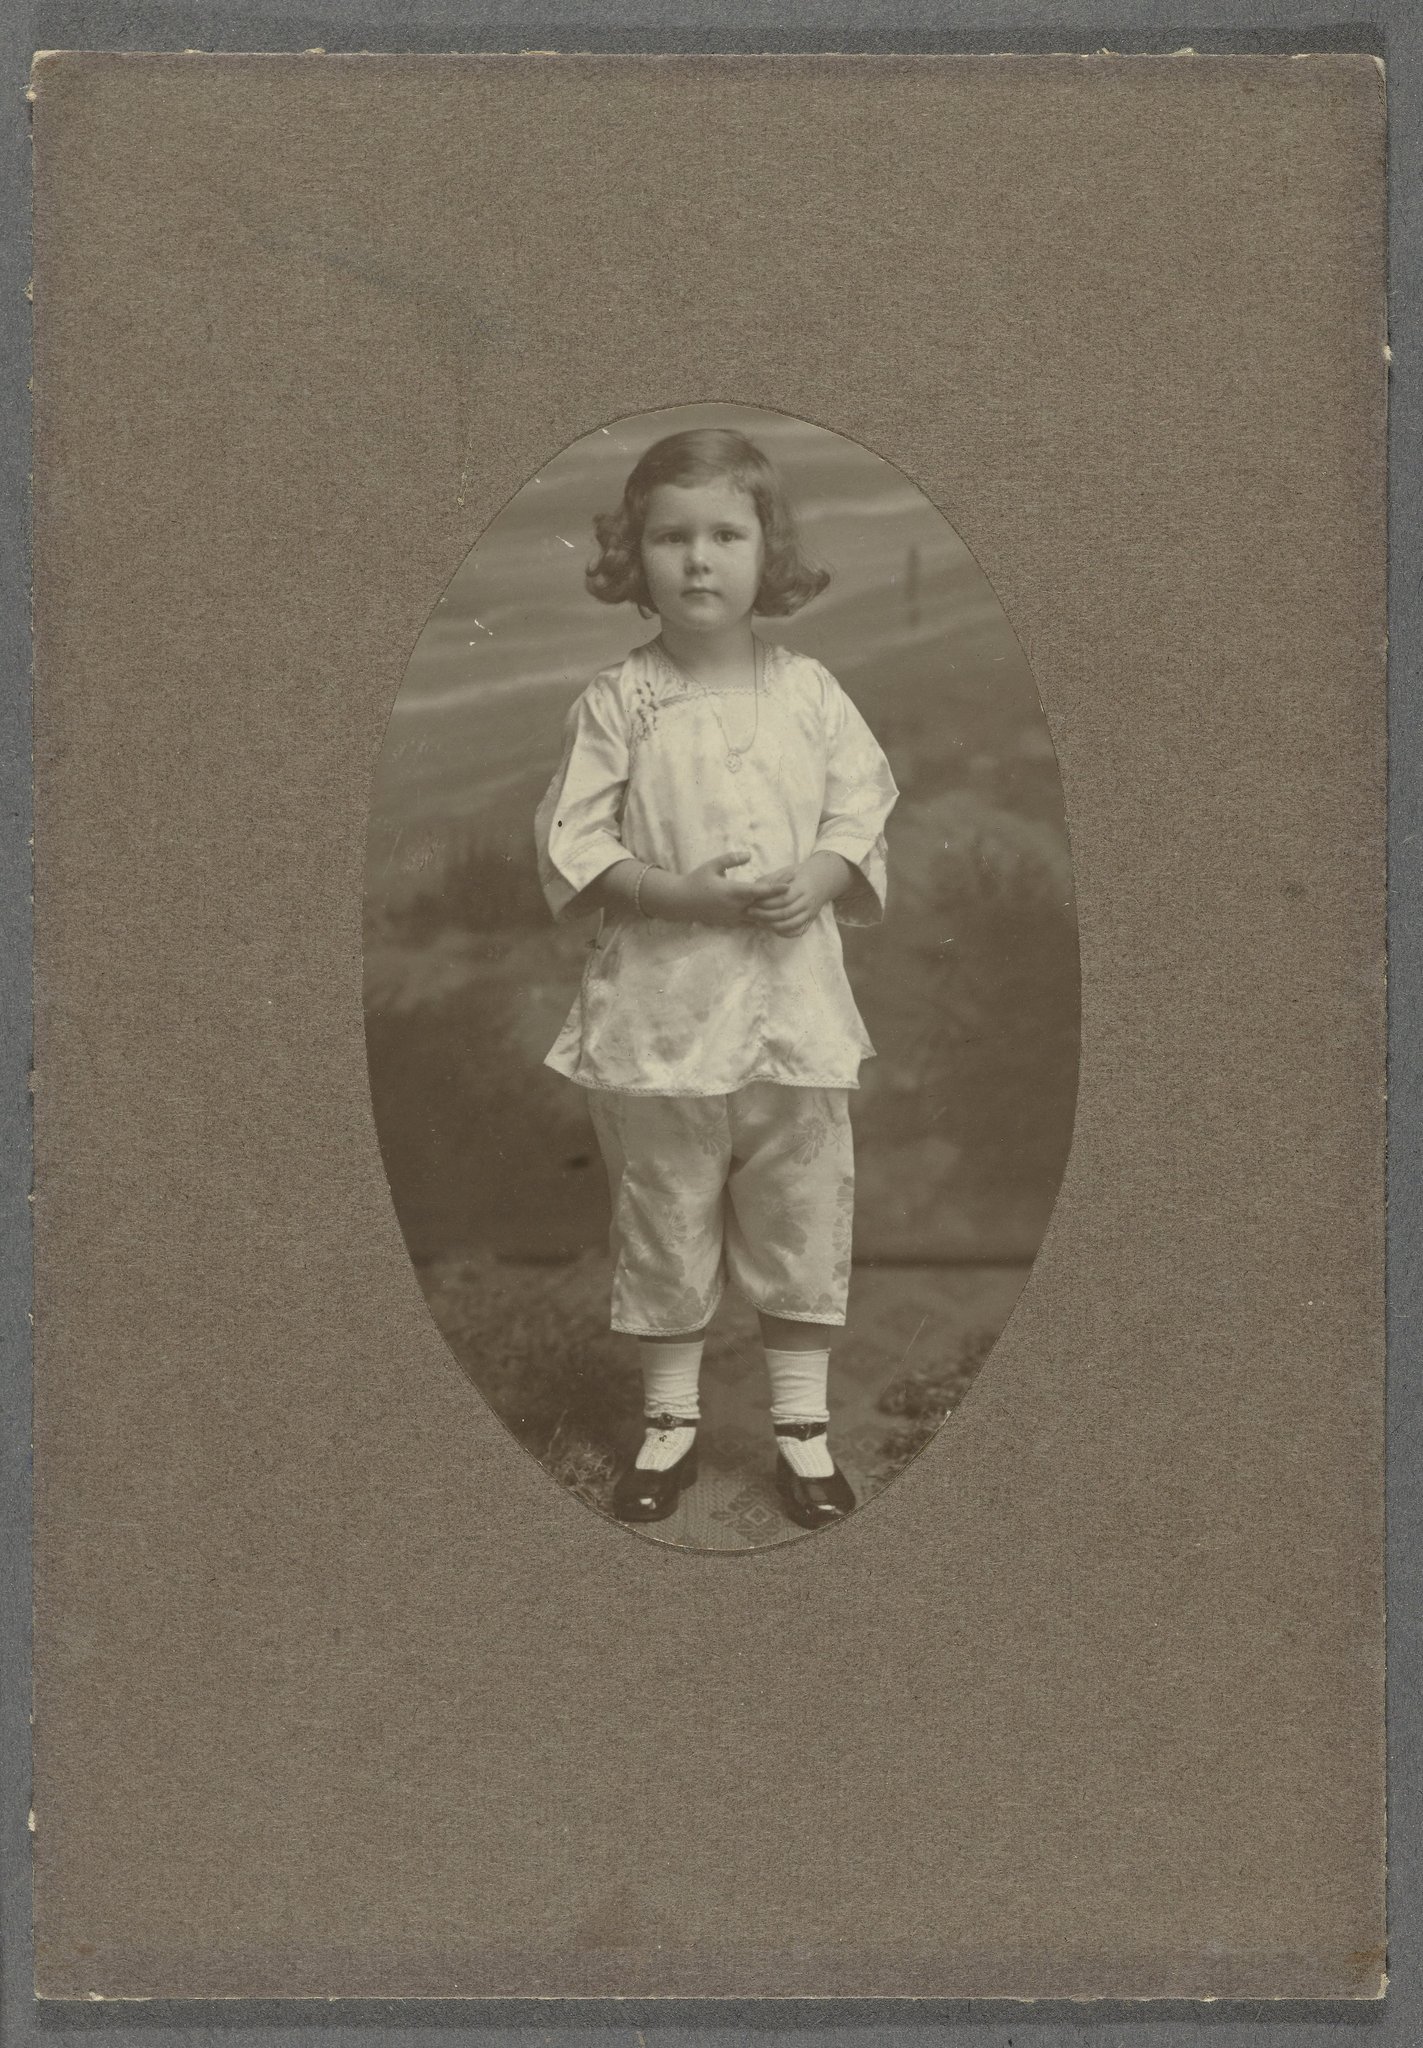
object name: photograph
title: Portret van Tiny Kleiterp als kleuter in een pakje met driekwart mouwen en broek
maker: klaas kleiterp (i)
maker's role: arts, officier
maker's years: 1892-1943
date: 1924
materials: cardboard, paper, photographic support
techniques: daylight paper print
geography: dutch east indies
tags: studio requisites ~ photographer, child, dutch east indies, the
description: Onderdeel van Fotoalbum van de familie Kleiterp-Vermeulen met opnames van de kinderen Klaas en Tiny in Nederlands-Indië.